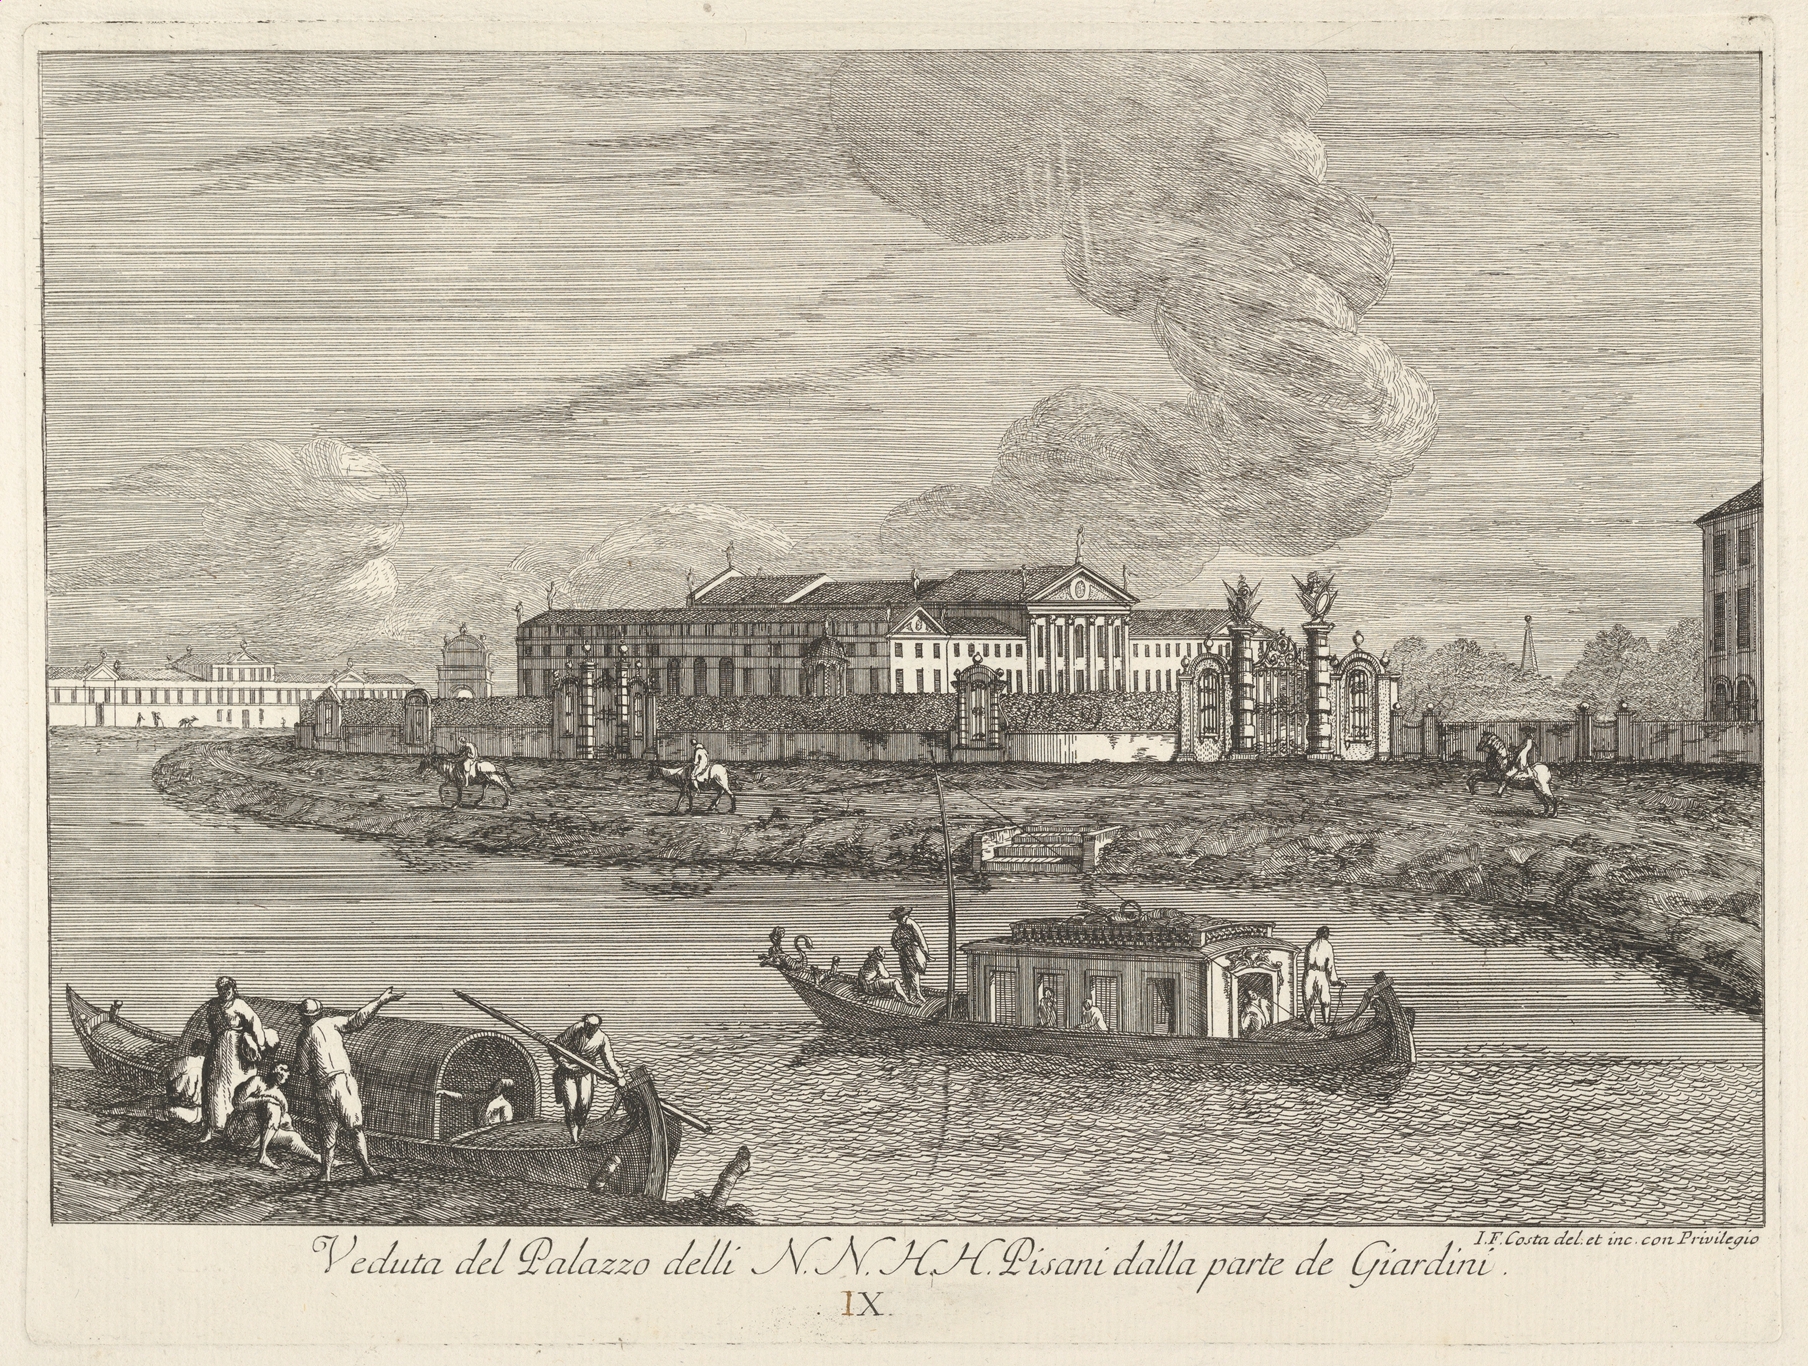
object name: print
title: View of the Villa Pisani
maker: giovanni francesco costa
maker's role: artist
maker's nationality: italian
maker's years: 1711-1773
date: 1730-1772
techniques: etching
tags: buildings,boats